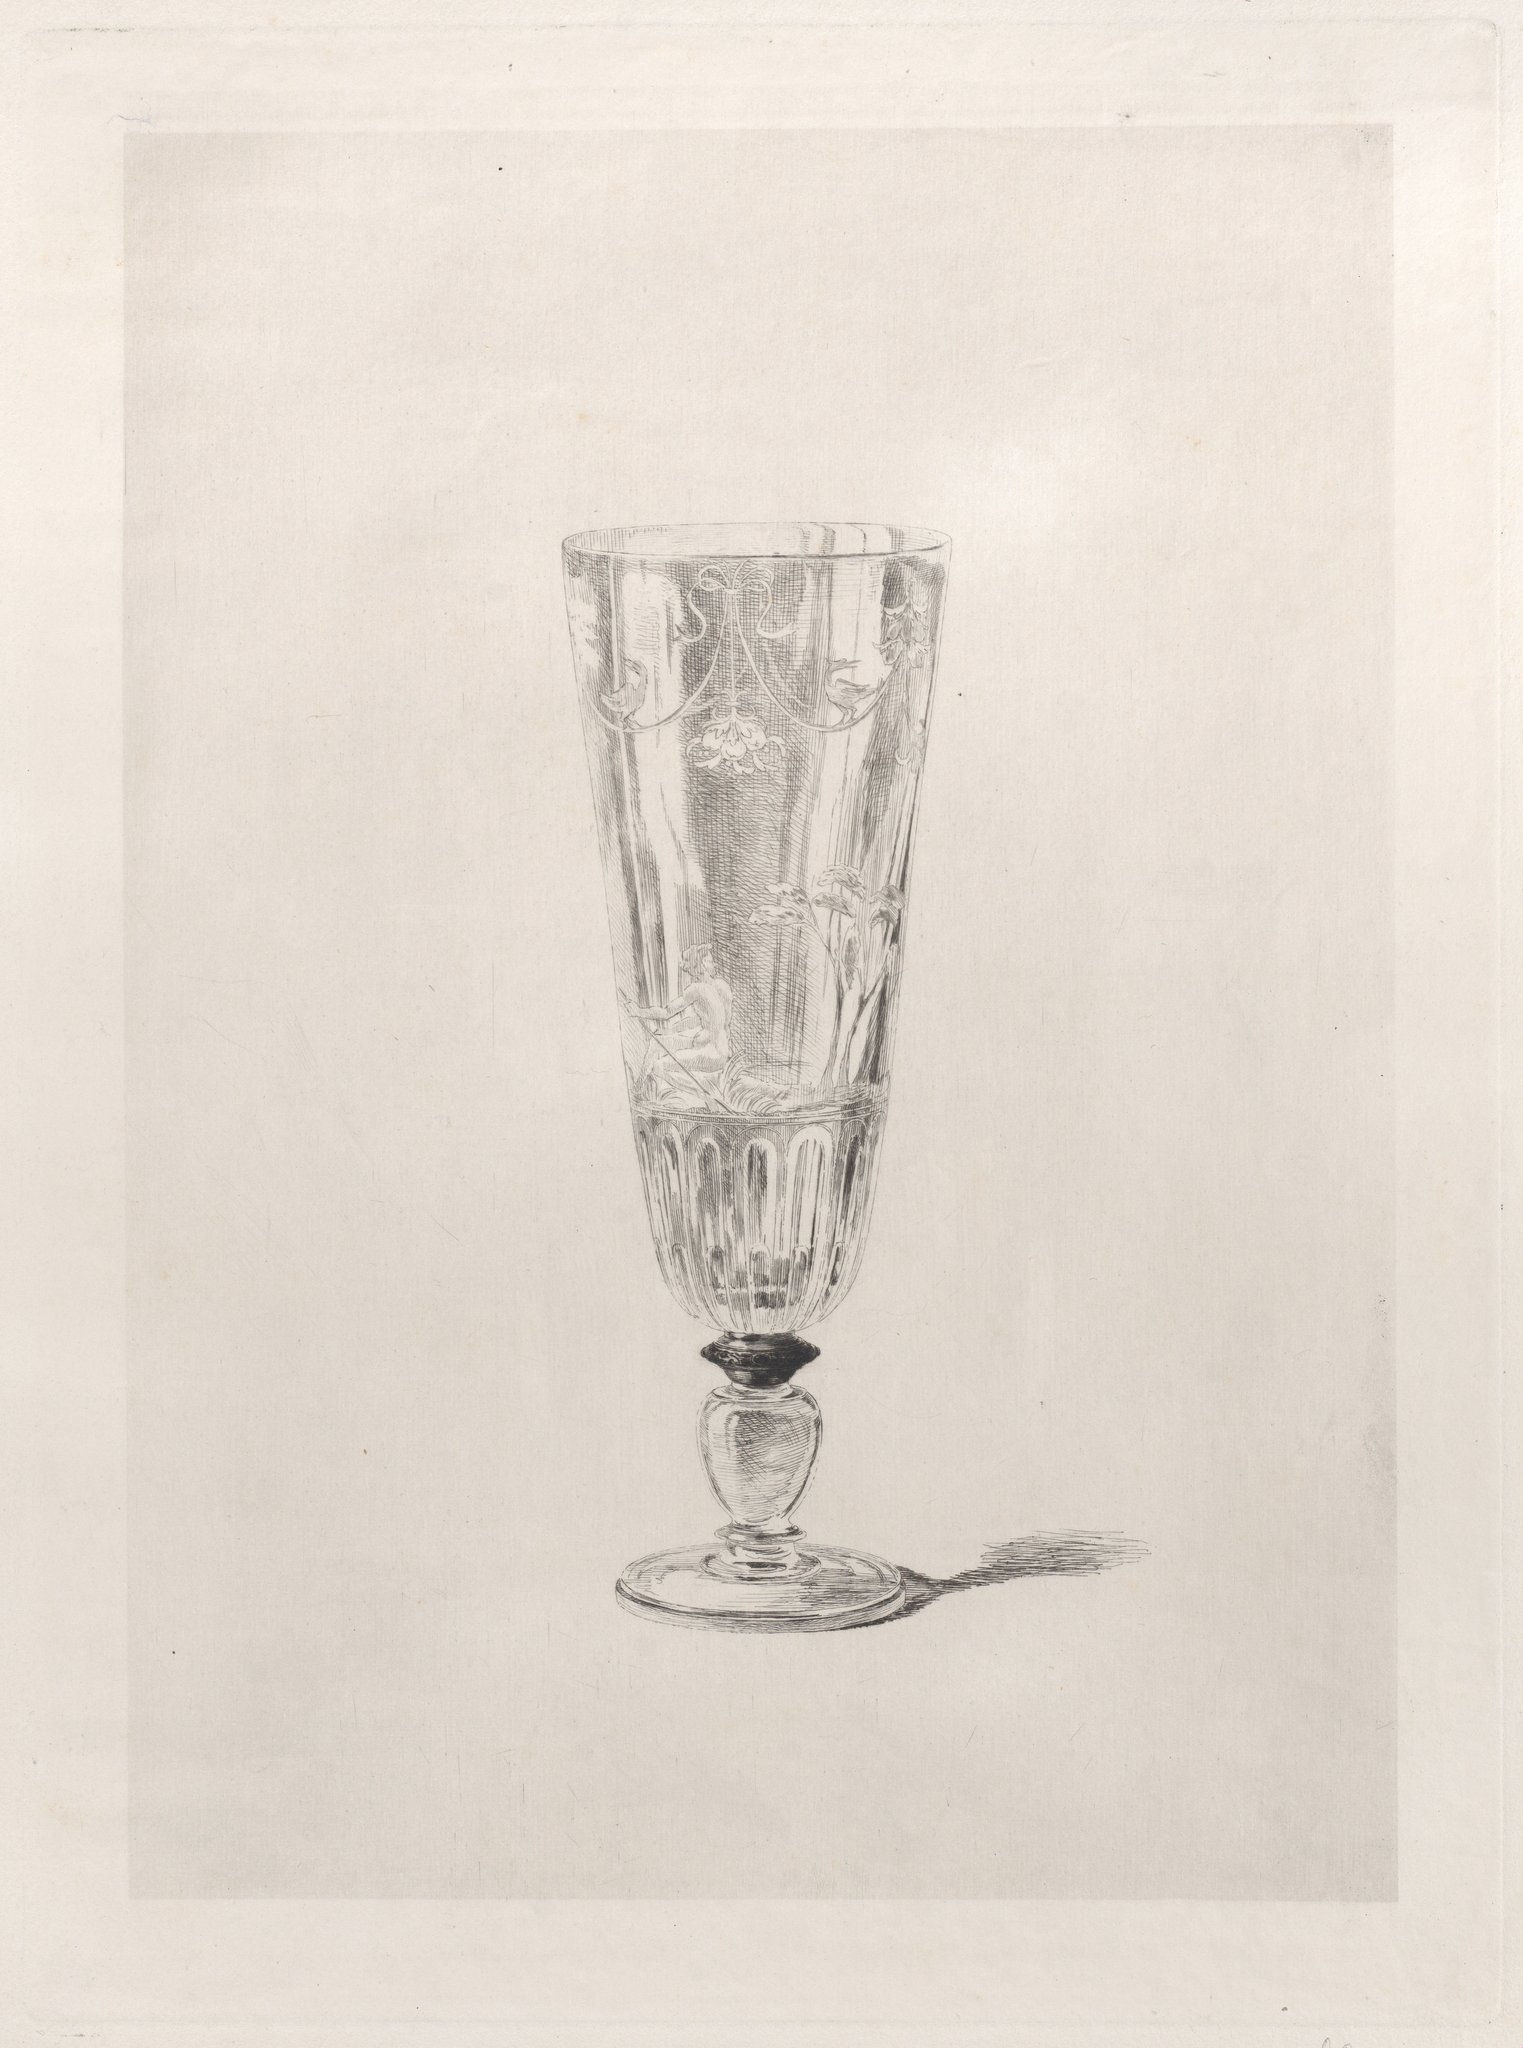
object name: print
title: Crystal Drinking Glass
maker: jules-ferdinand jacquemart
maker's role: artist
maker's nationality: french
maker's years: 1837-1880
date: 1868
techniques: etching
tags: drinking glasses